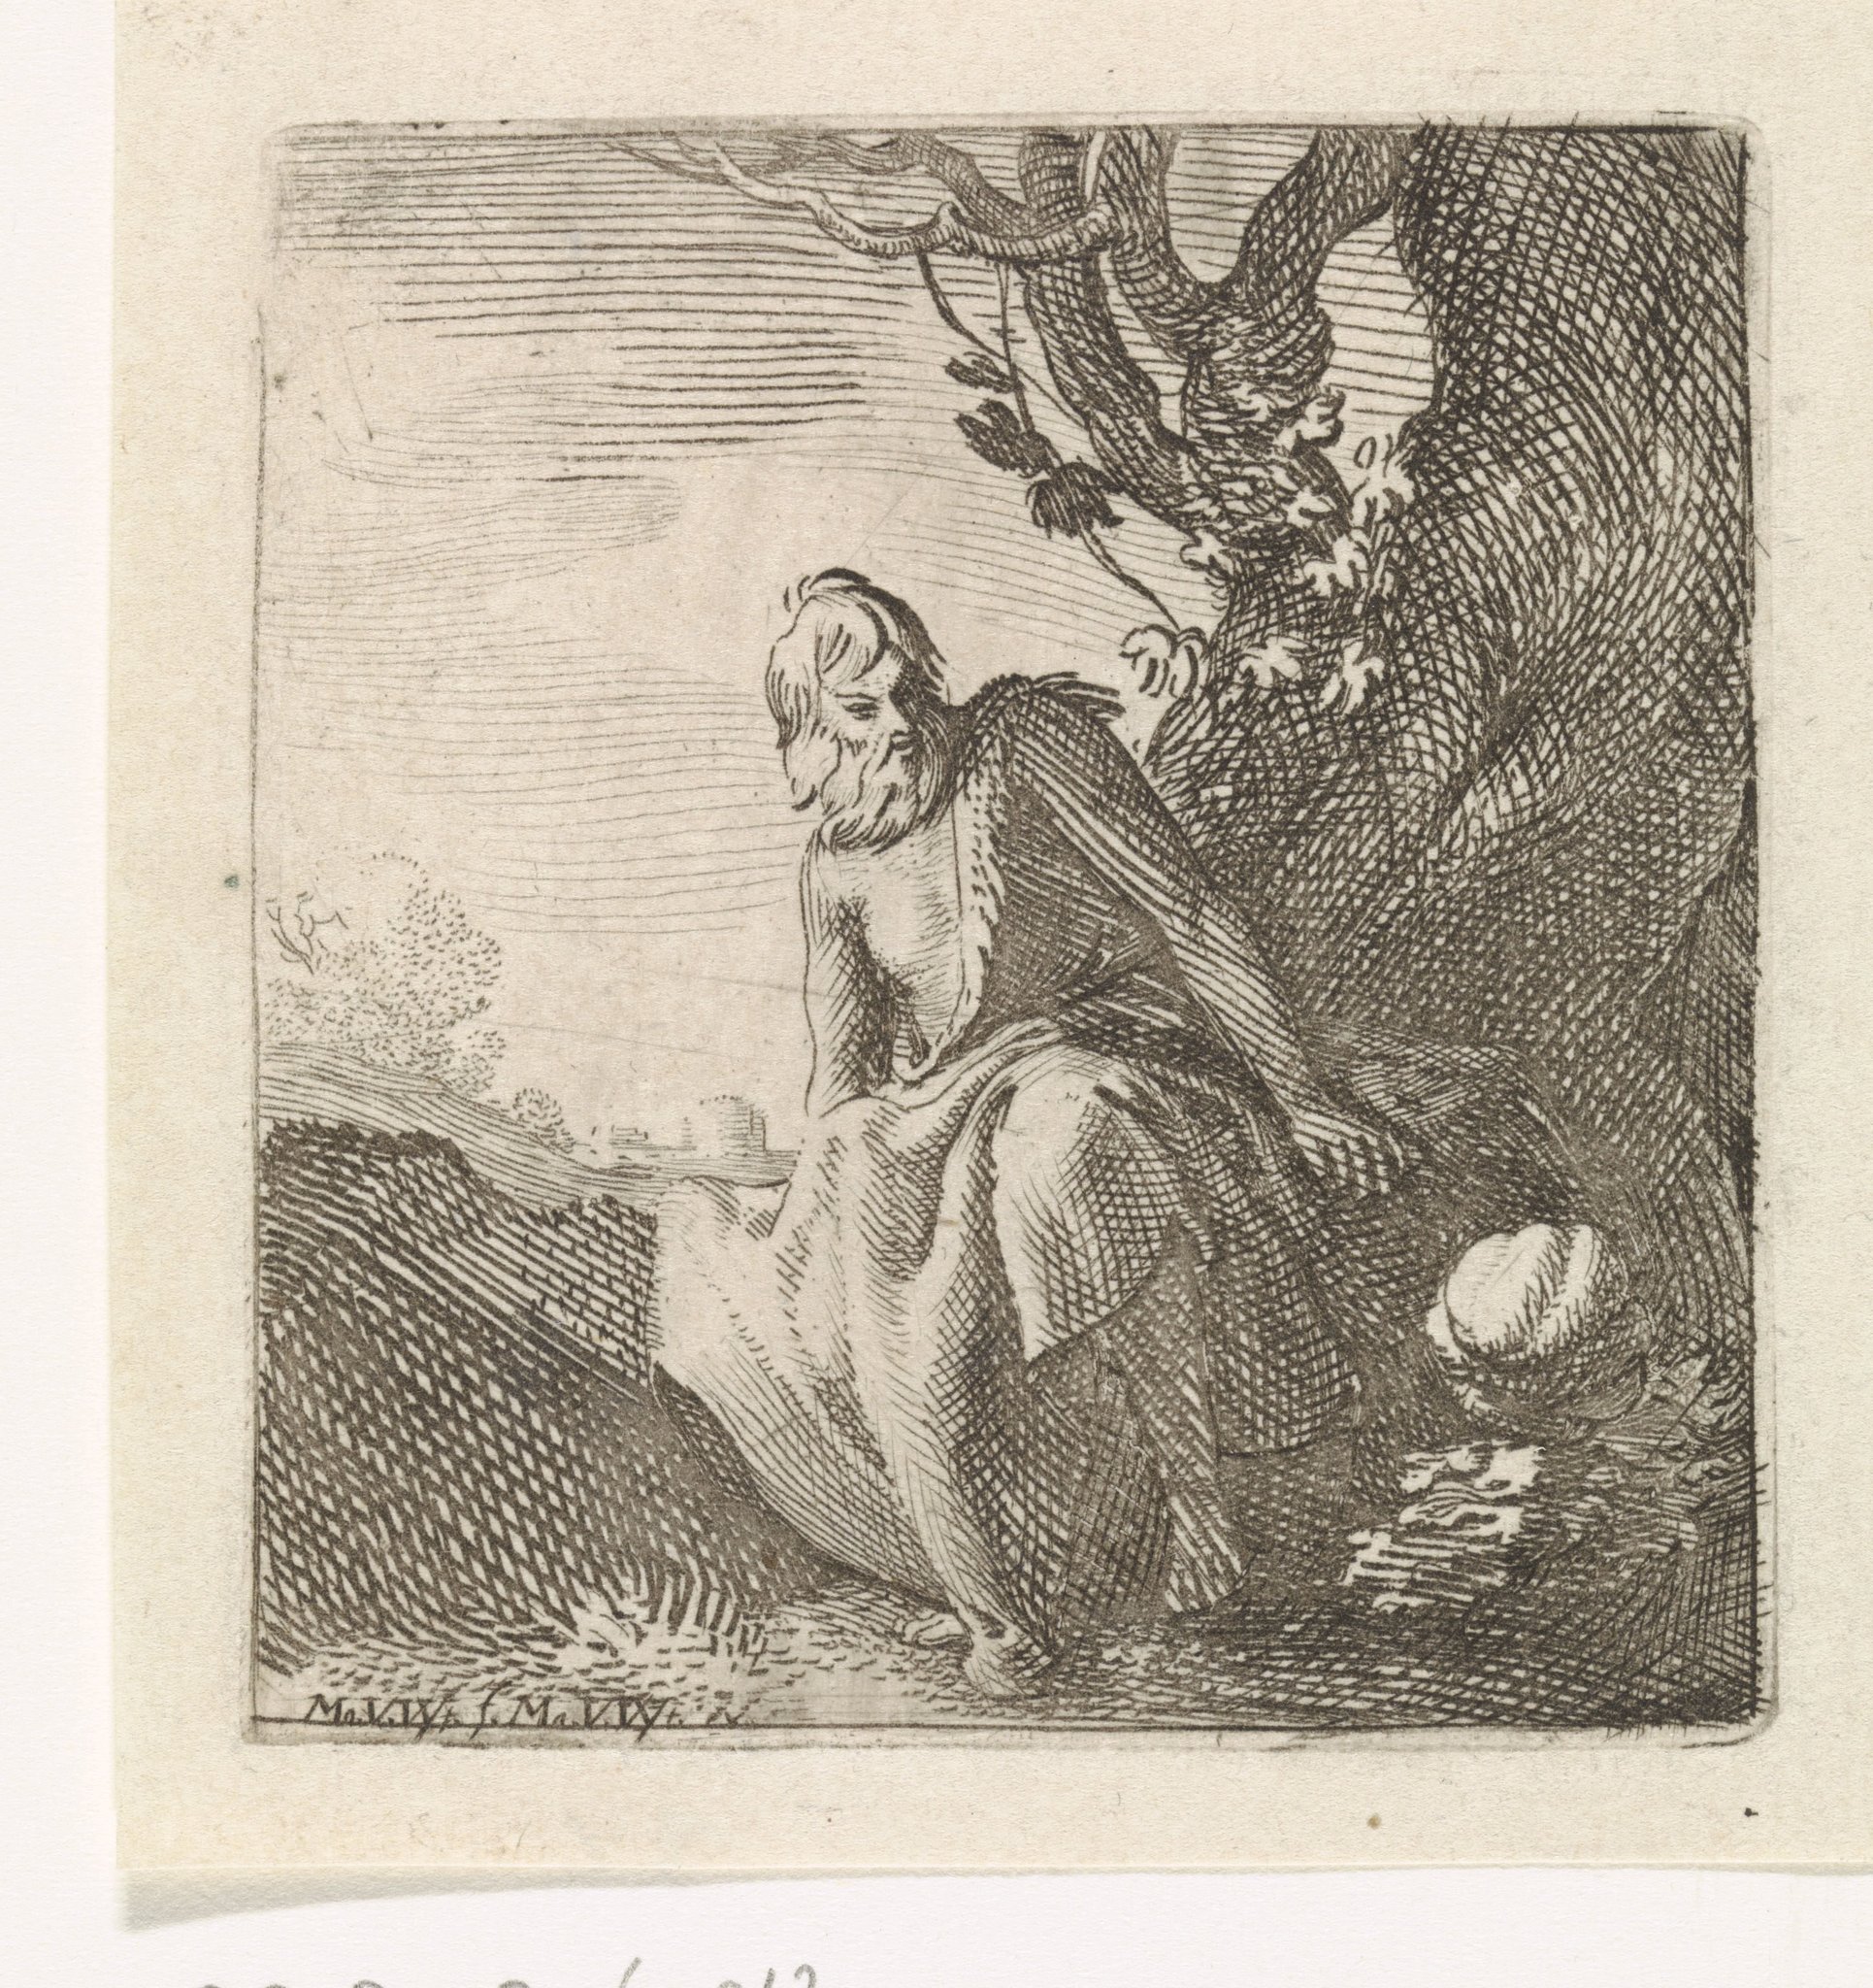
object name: print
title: Man met pompoen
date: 1600-1647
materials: paper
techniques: engraving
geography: antwerp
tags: story of elisha (eliseus), the gourd (or vine) is eaten by a worm and jonah is exposed to the burning rays of the sun, fruits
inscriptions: collector's mark: Lugt 240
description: Een man met baard zit naast een grote pompoen. De man stelt mogelijk de profeet Jonah voor (zie Jonah 4:6-7) of de man die wilde pompoenen verzamelde voor Elisha (zie 2 Koningen 4:38-41).